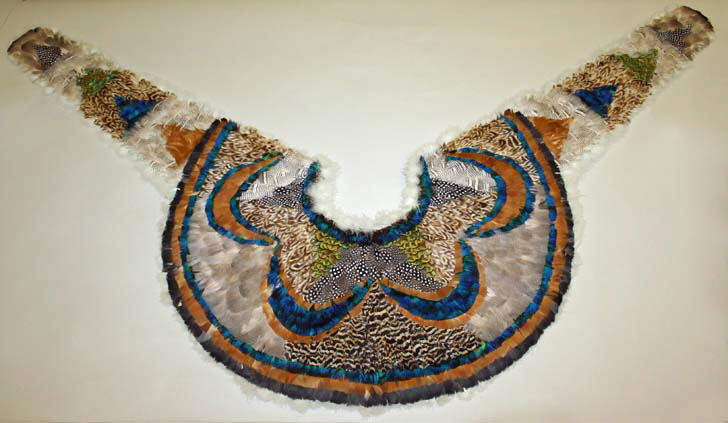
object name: pelerine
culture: european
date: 1840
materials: cotton, feather